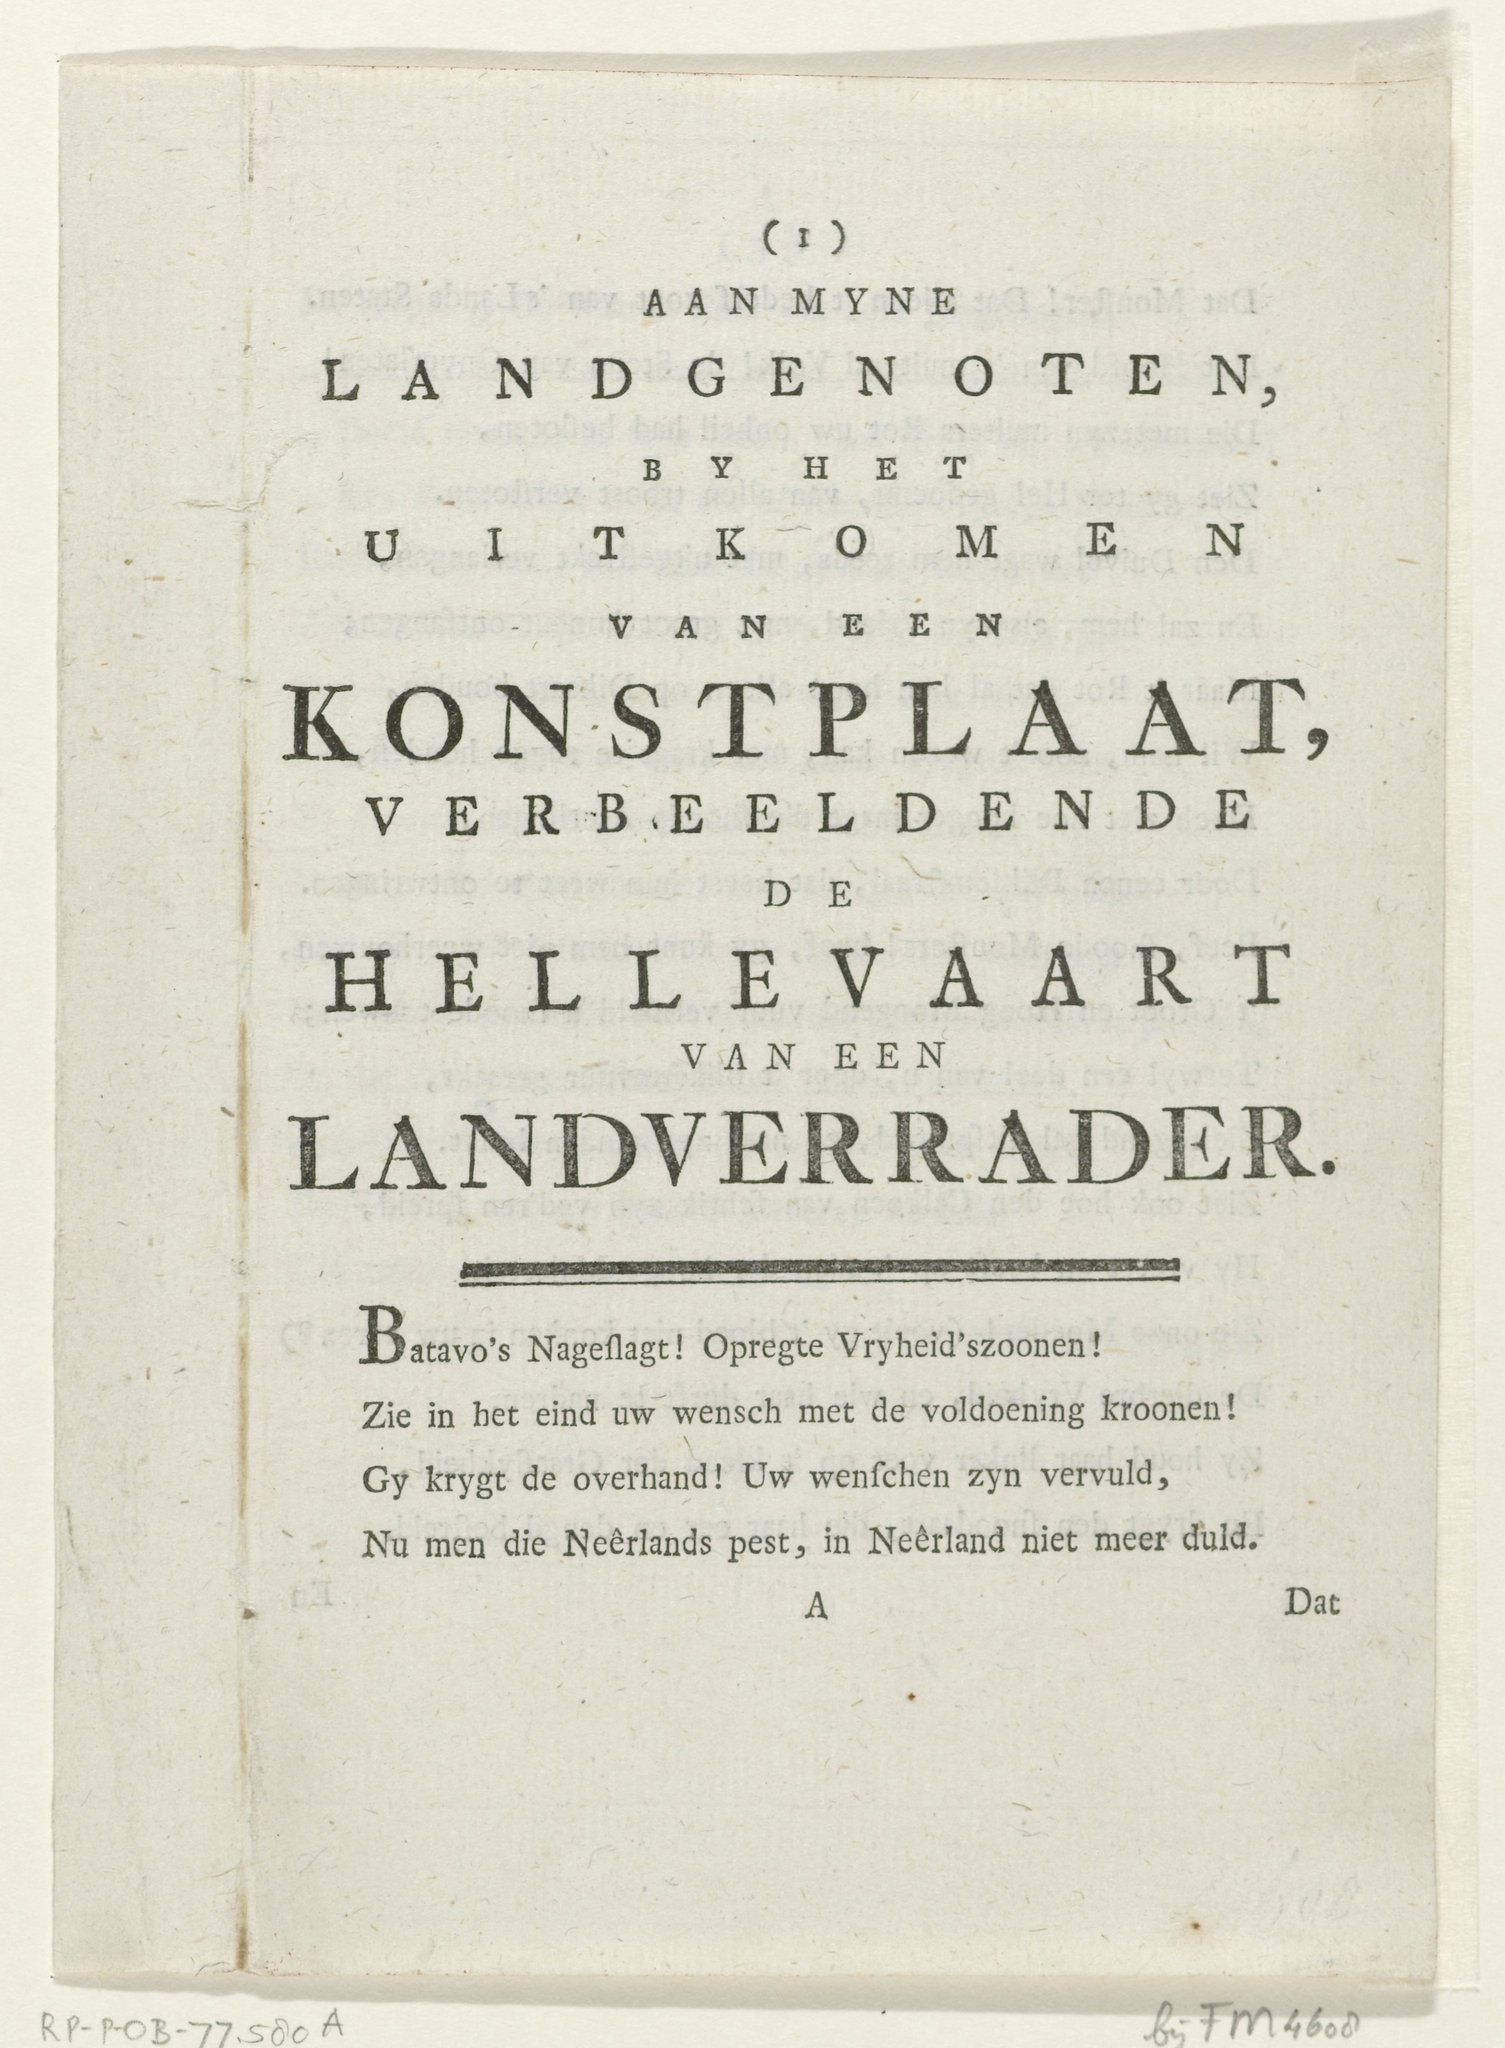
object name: text sheet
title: Aan myne Landgenoten, by het Uitkomen van een Konstplaat, verbeeldende de Hellevaart van een Landverrader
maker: Anonymous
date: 1784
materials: paper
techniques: letterpress printing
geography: northern netherlands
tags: the hague, william v (prince of orange), ludwig ernst von braunschweig-wolfenbüttel, patriots (1780-1795)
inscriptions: collector's mark: Lugt 2228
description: Tekstblad met een vers op de spotprent de Hellevaart van een Landverrader, naar aanleiding van het vertrek van de hertog van Brunswijk uit Nederland, 14 oktober 1784. Dubbelgevouwen blad bedrukt op drie zijden.